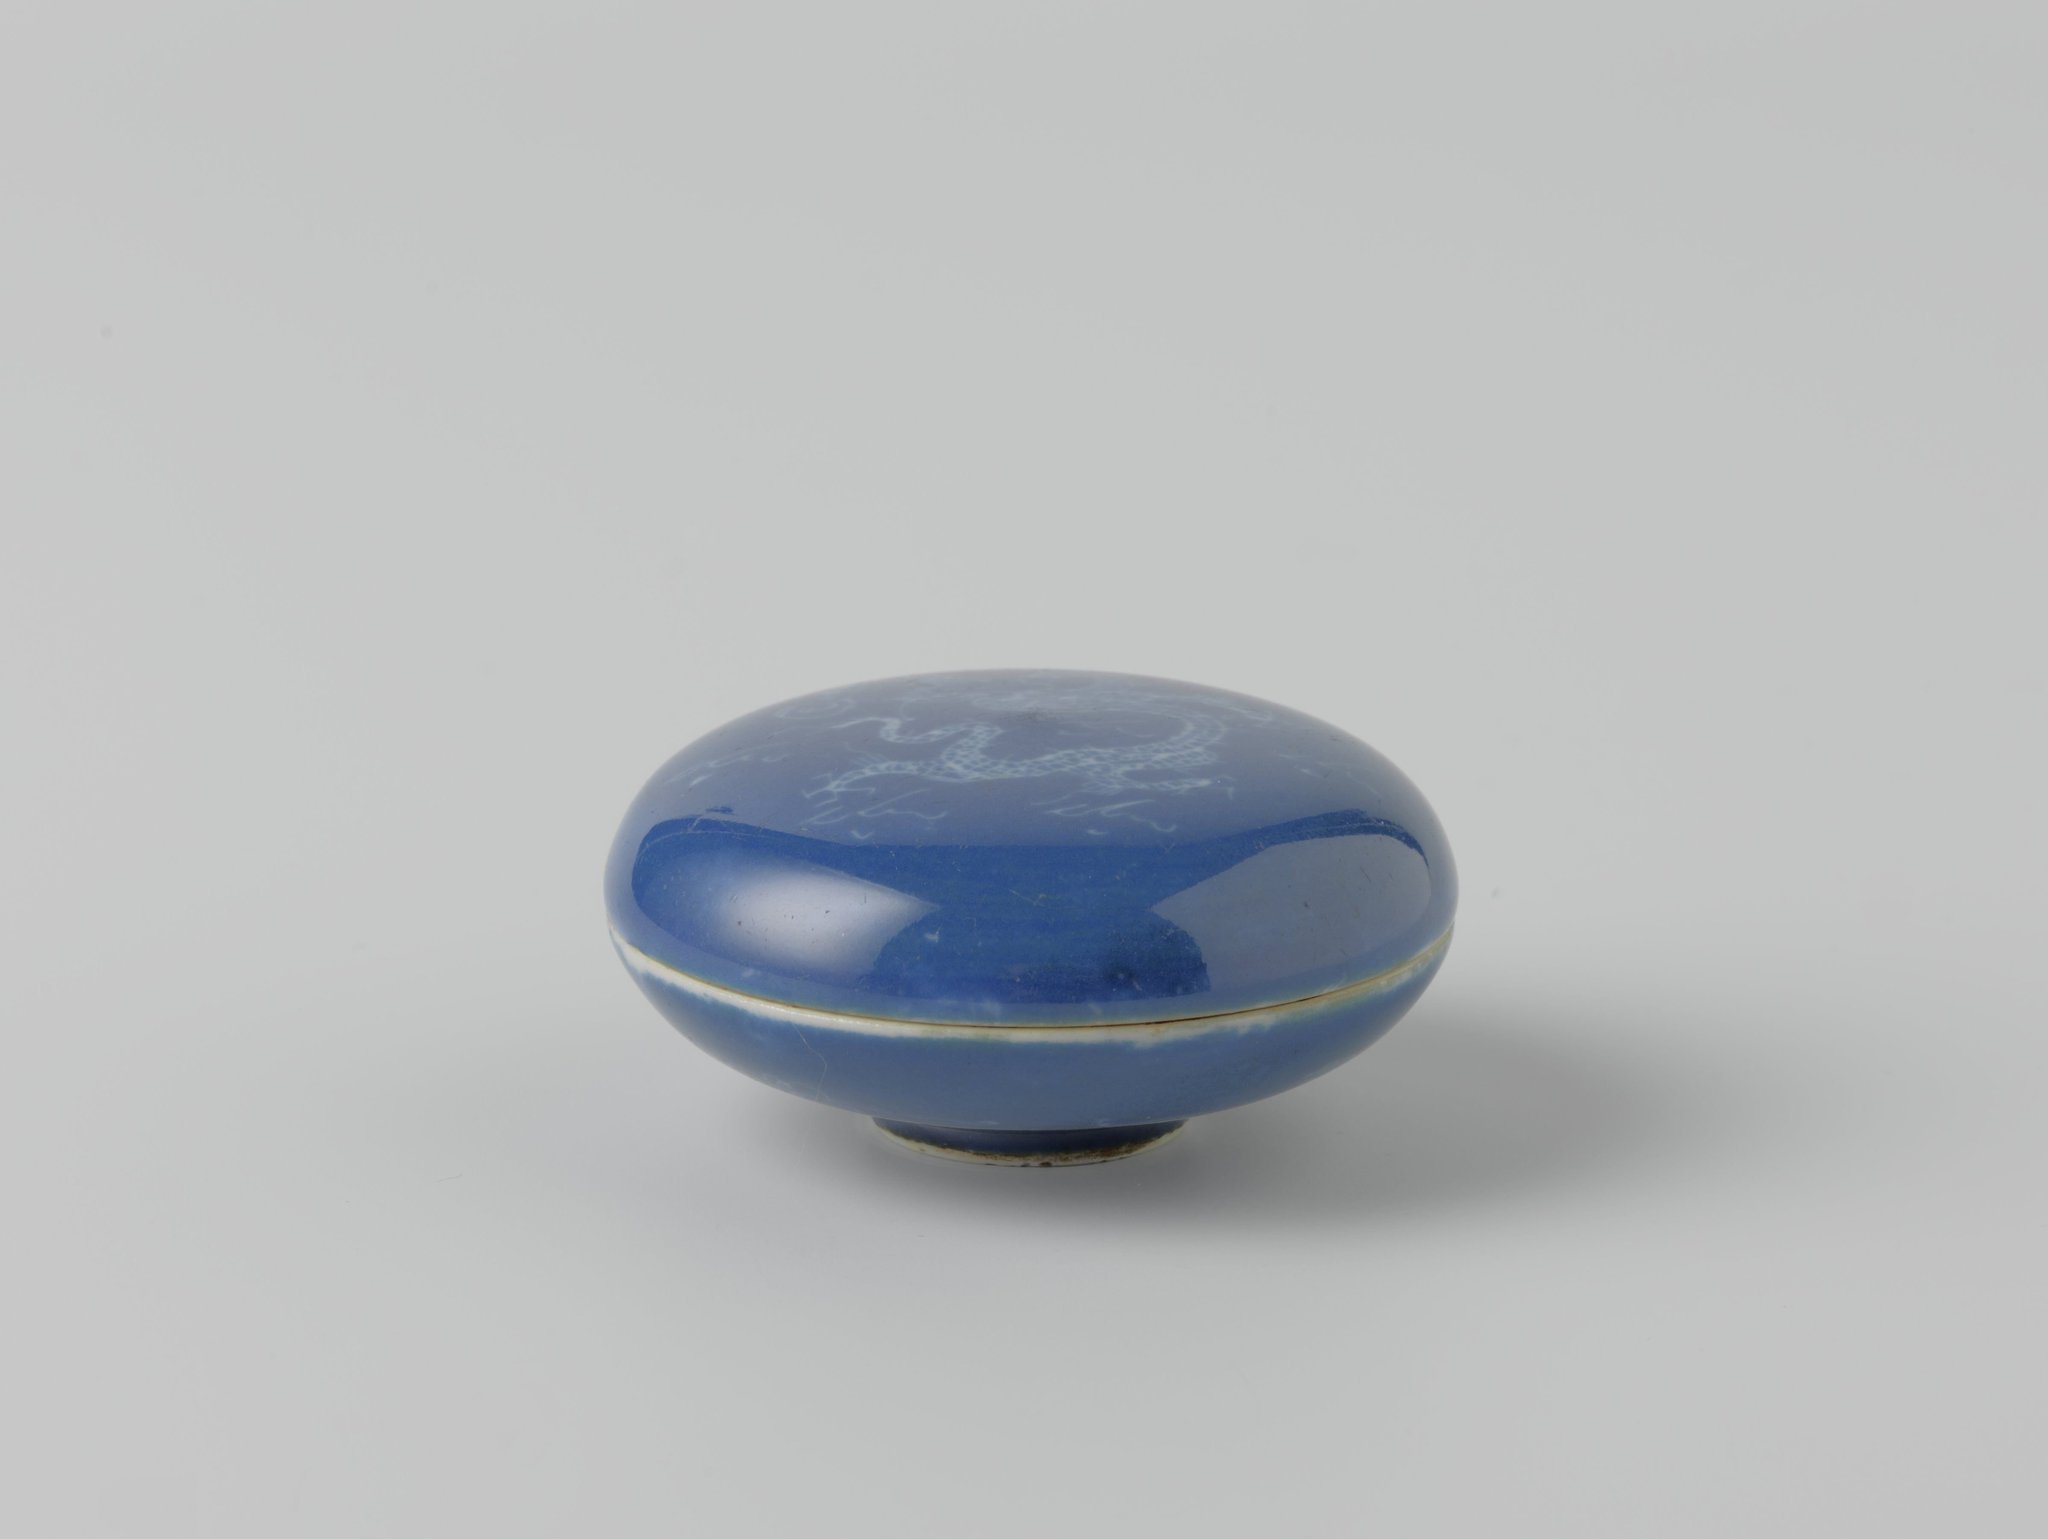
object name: box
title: Round box with powder blue and a dragon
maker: Anonymous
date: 1700-1724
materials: cobalt, glaze, paint, porcelain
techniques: firing, turning, vitrification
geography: china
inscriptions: mark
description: Deksel van ronde doos van porselein, beschilderd met onderglazuur blauw. De doos is bedekt met bleu poudré (poederblauw) met hierin uitgespaard op de deksel een vierklauwige draak die een parel achterna zit. Gemerkt op de onderzijde met een artimisiablad. Bleu poudré.